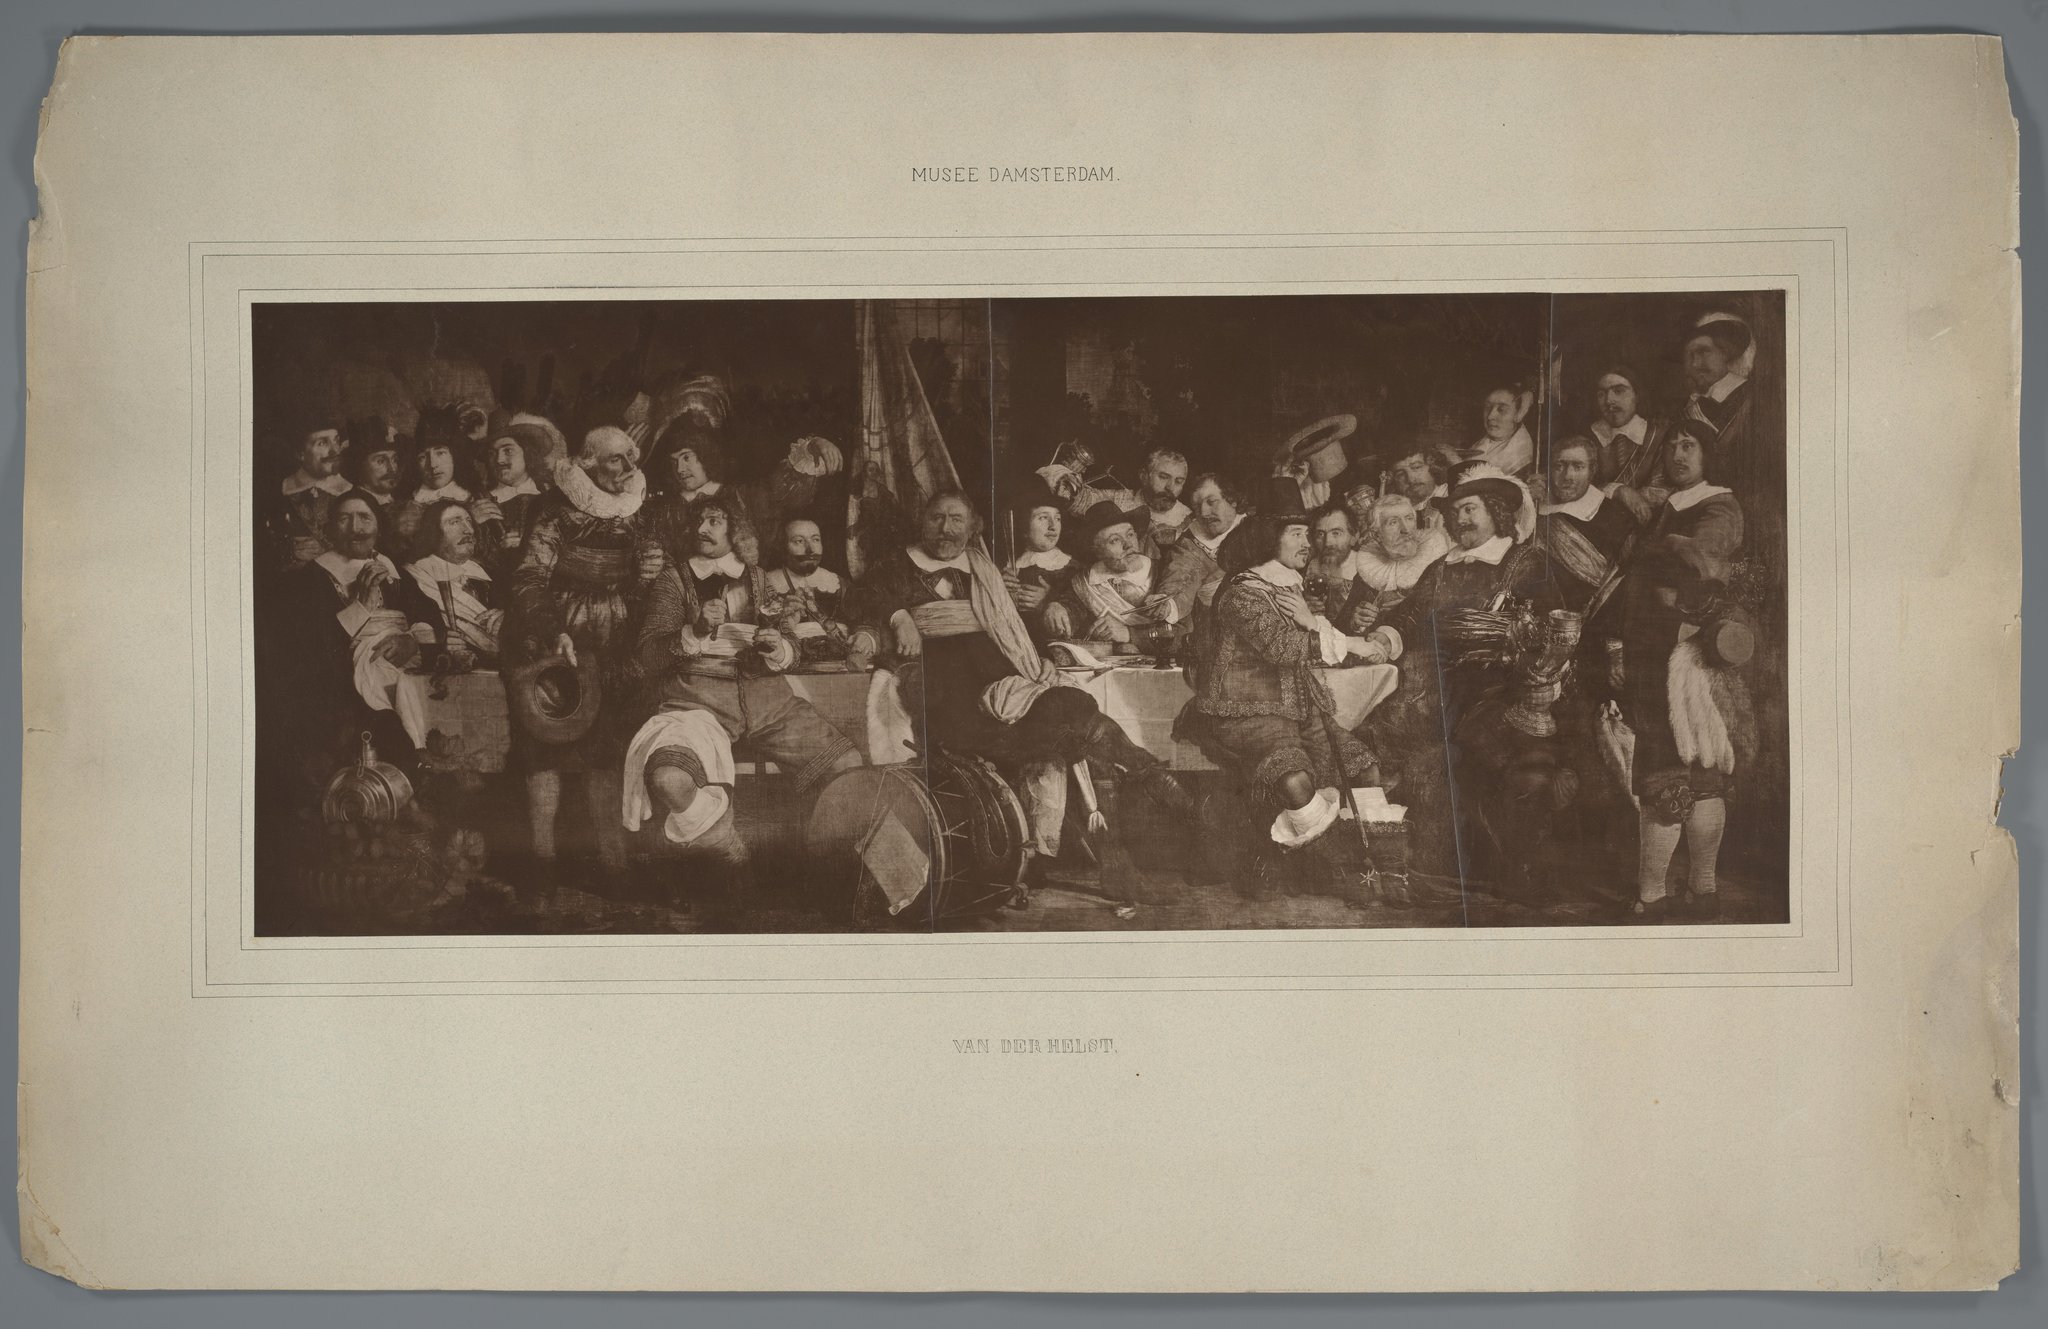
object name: reproduction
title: Fotoreproductie van het schilderij Schuttersmaaltijd ter viering van de Vrede van Munster door Bartholomeus van der Helst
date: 1864-1930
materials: cardboard, paper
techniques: carbon print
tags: mayor, cornelis witsen, celebration meal, feast, banquet, picture, painting, private festivities, merry company, amsterdam